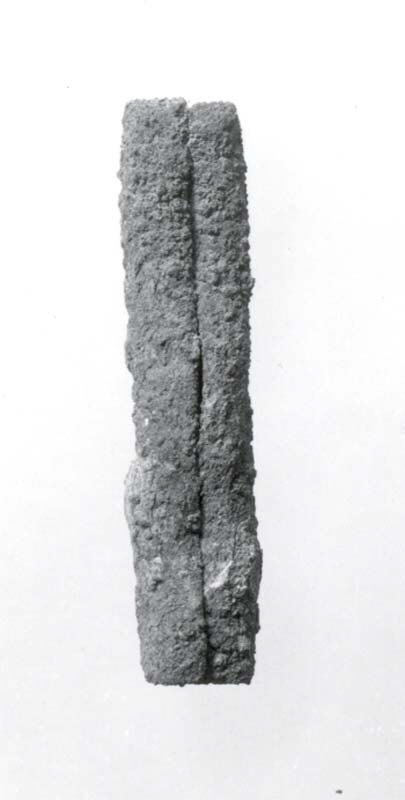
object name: tube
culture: assyrian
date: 900-601 BCE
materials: bronze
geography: mesopotamia